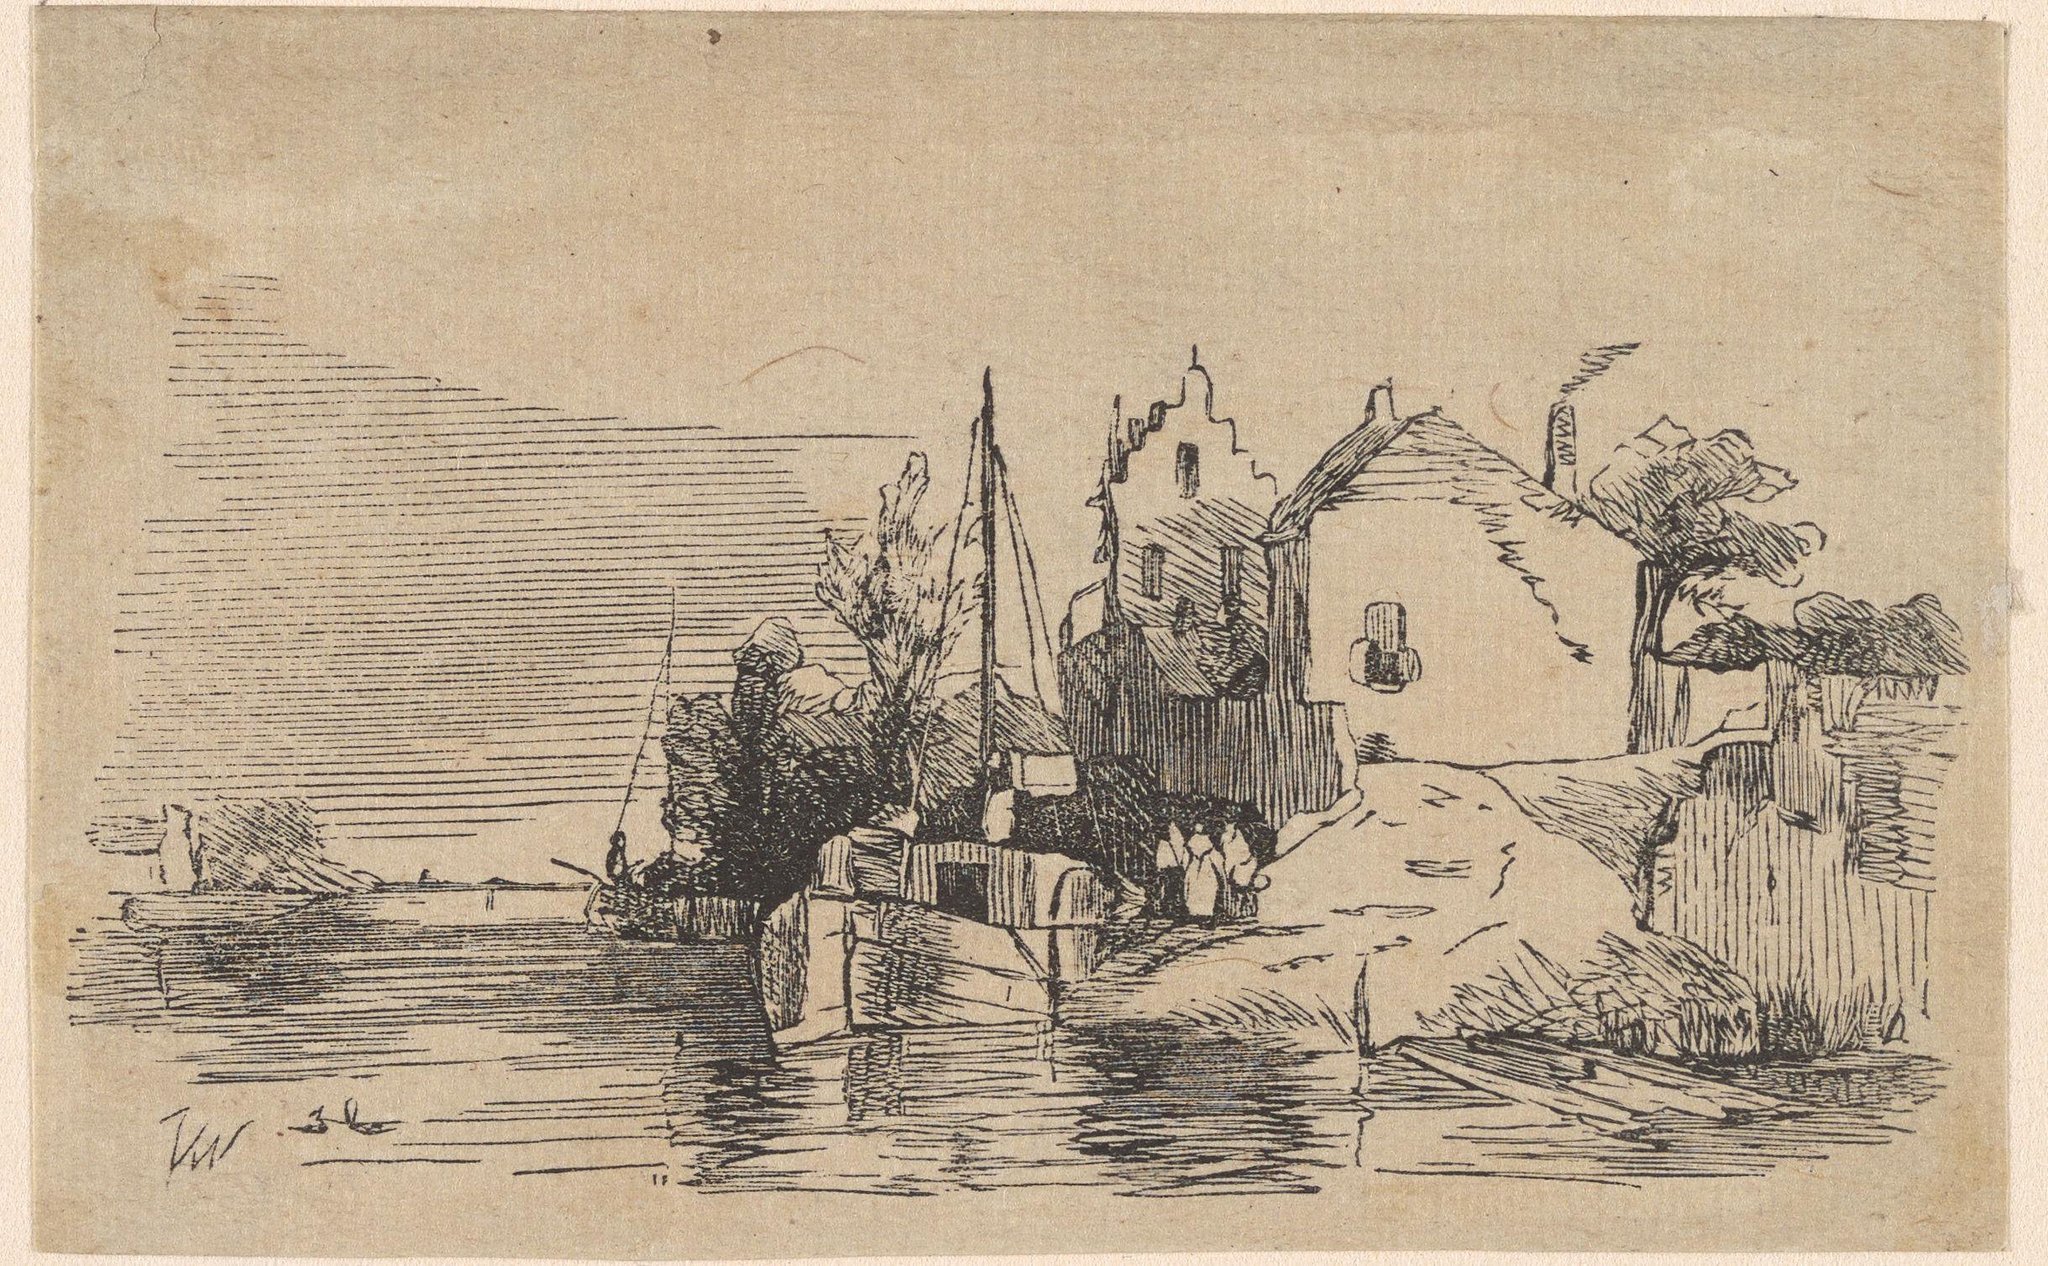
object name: print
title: Rivierlandschap met een aantal schepen en huizen aan het water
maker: isaac weissenbruch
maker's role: print maker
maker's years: 1826-1912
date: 1836-1912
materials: paper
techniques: engraving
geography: netherlands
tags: sailing-ship, sailing-boat, river, farm or solitary house in landscape